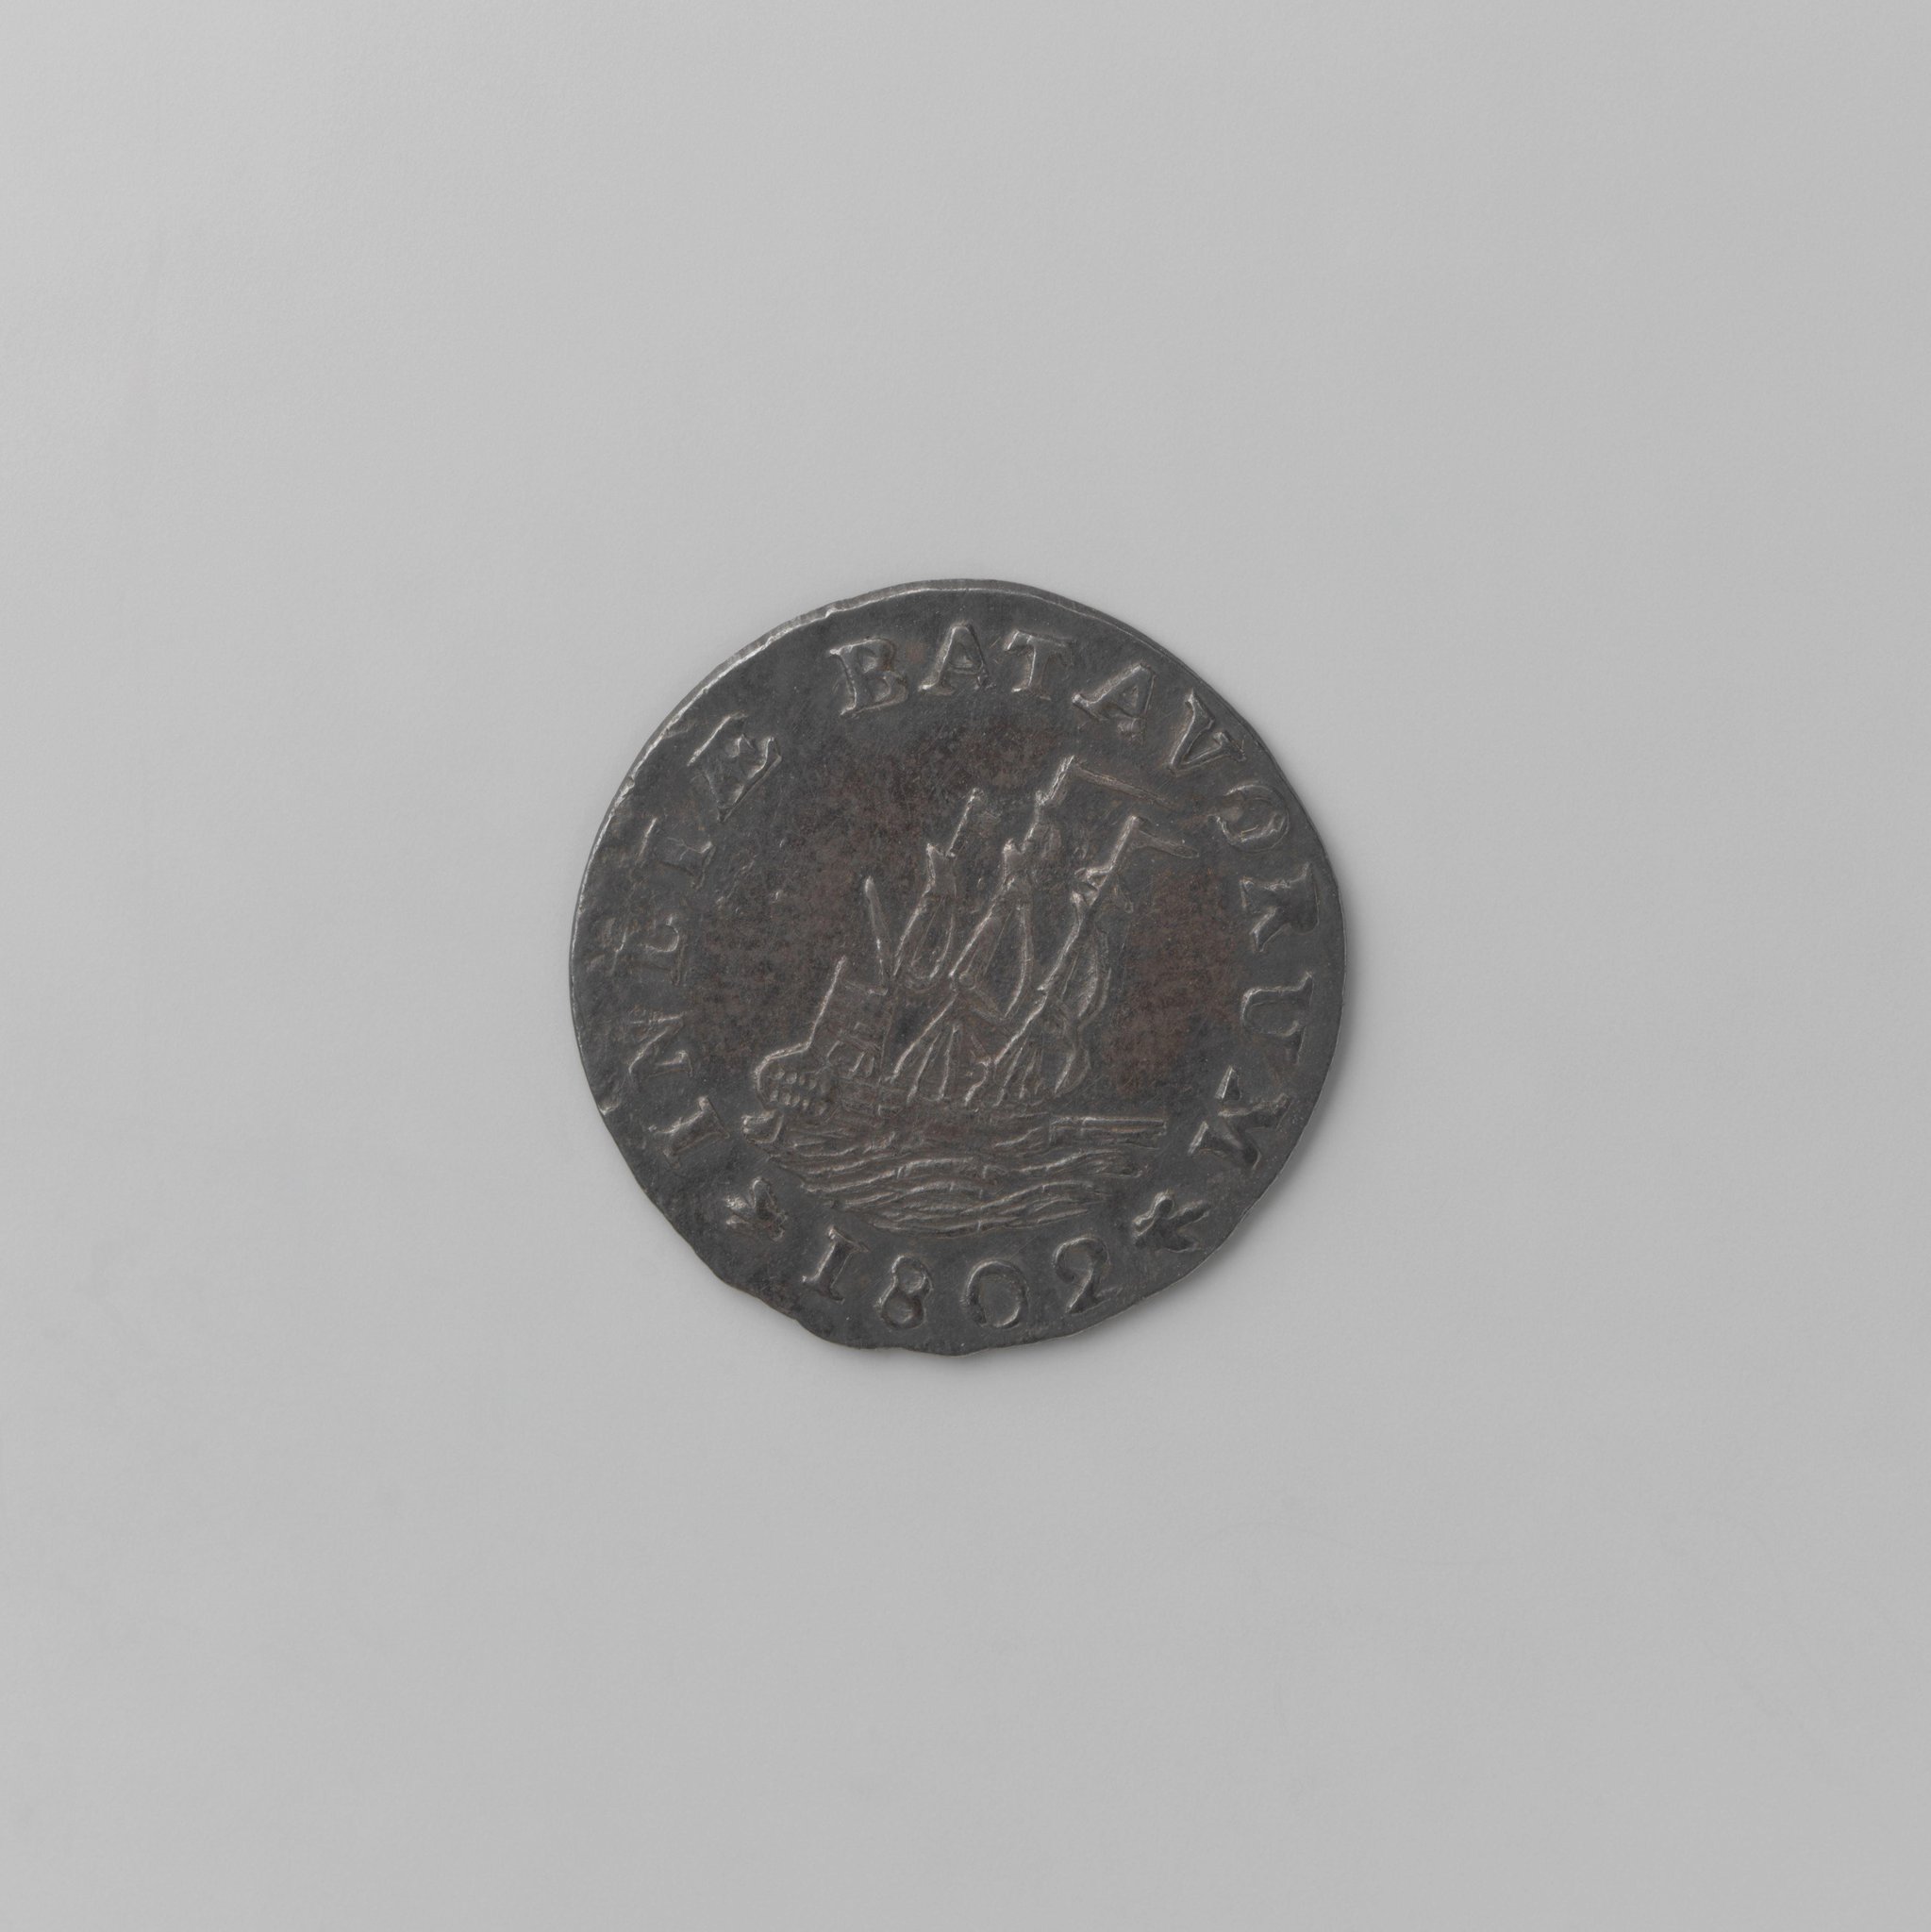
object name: coin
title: 1/16 scheepjesgulden, 1802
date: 1802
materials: silver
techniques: striking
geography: enkhuizen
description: Zilveren munt. Voorzijde: Driemaster met volle zeilen op open zee. Geen binnencirkel. Jaartal onderaan in omschrift. Keerzijde: tussen waarde-aanduiding 1/16 G gekroond generaliteitswapenschild. Muntteken boven kroon in omschrift. Gladde rand.